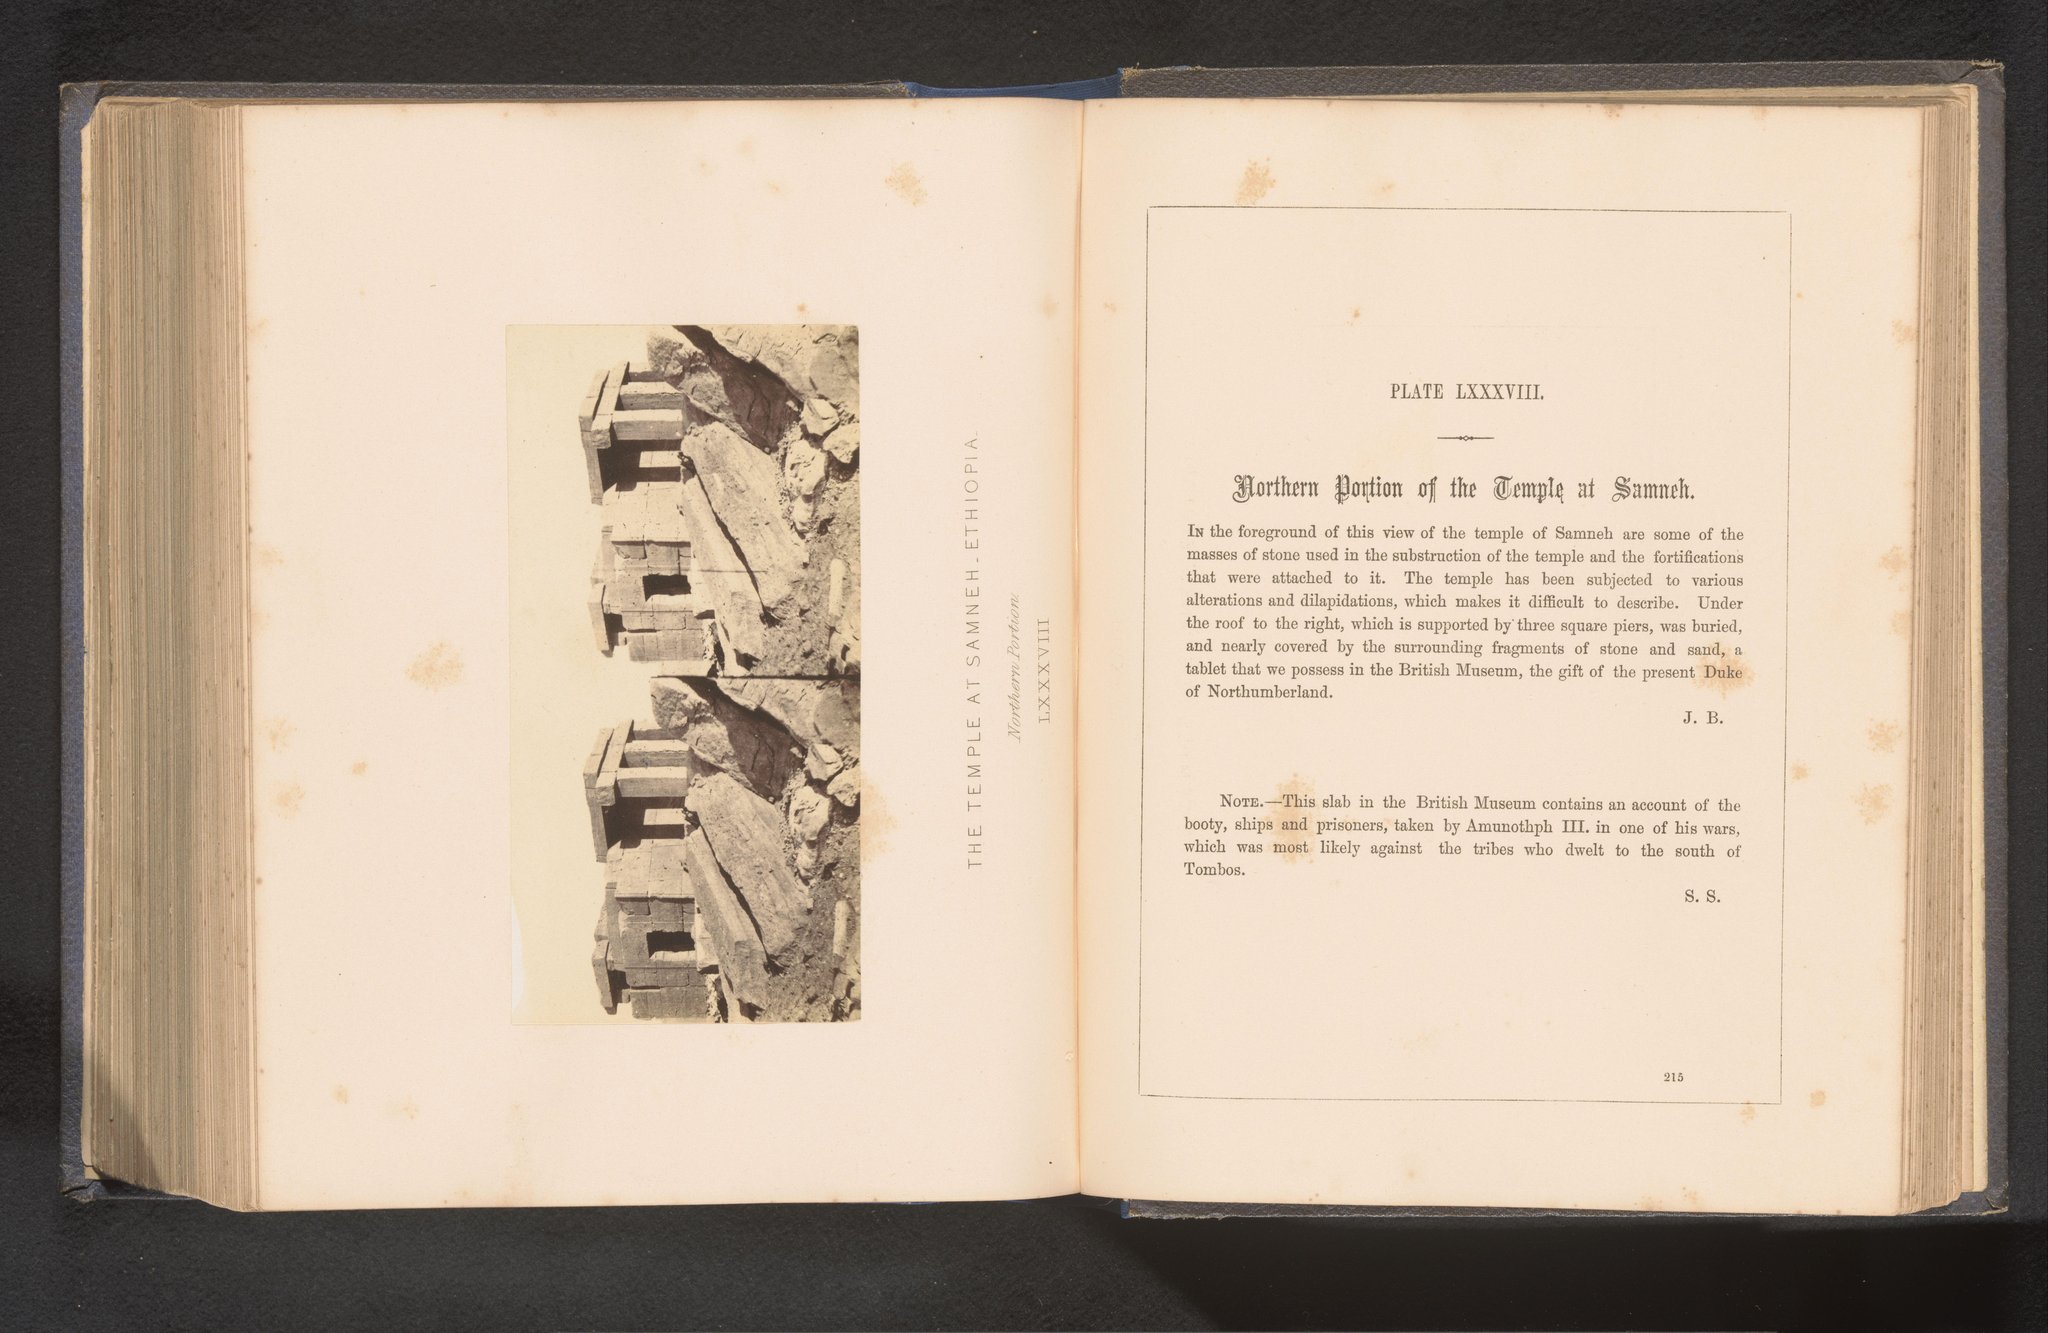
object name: stereograph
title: The temple at Samneh - Ethiopia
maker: francis frith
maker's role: publisher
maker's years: 1822-1898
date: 1857-1862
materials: photographic support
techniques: albumen print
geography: semna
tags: temple, shrine ~ egyptian religion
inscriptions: number: ‘LXXXVIII’, inscription: ‘Northern Portion’, name: ‘Frith’